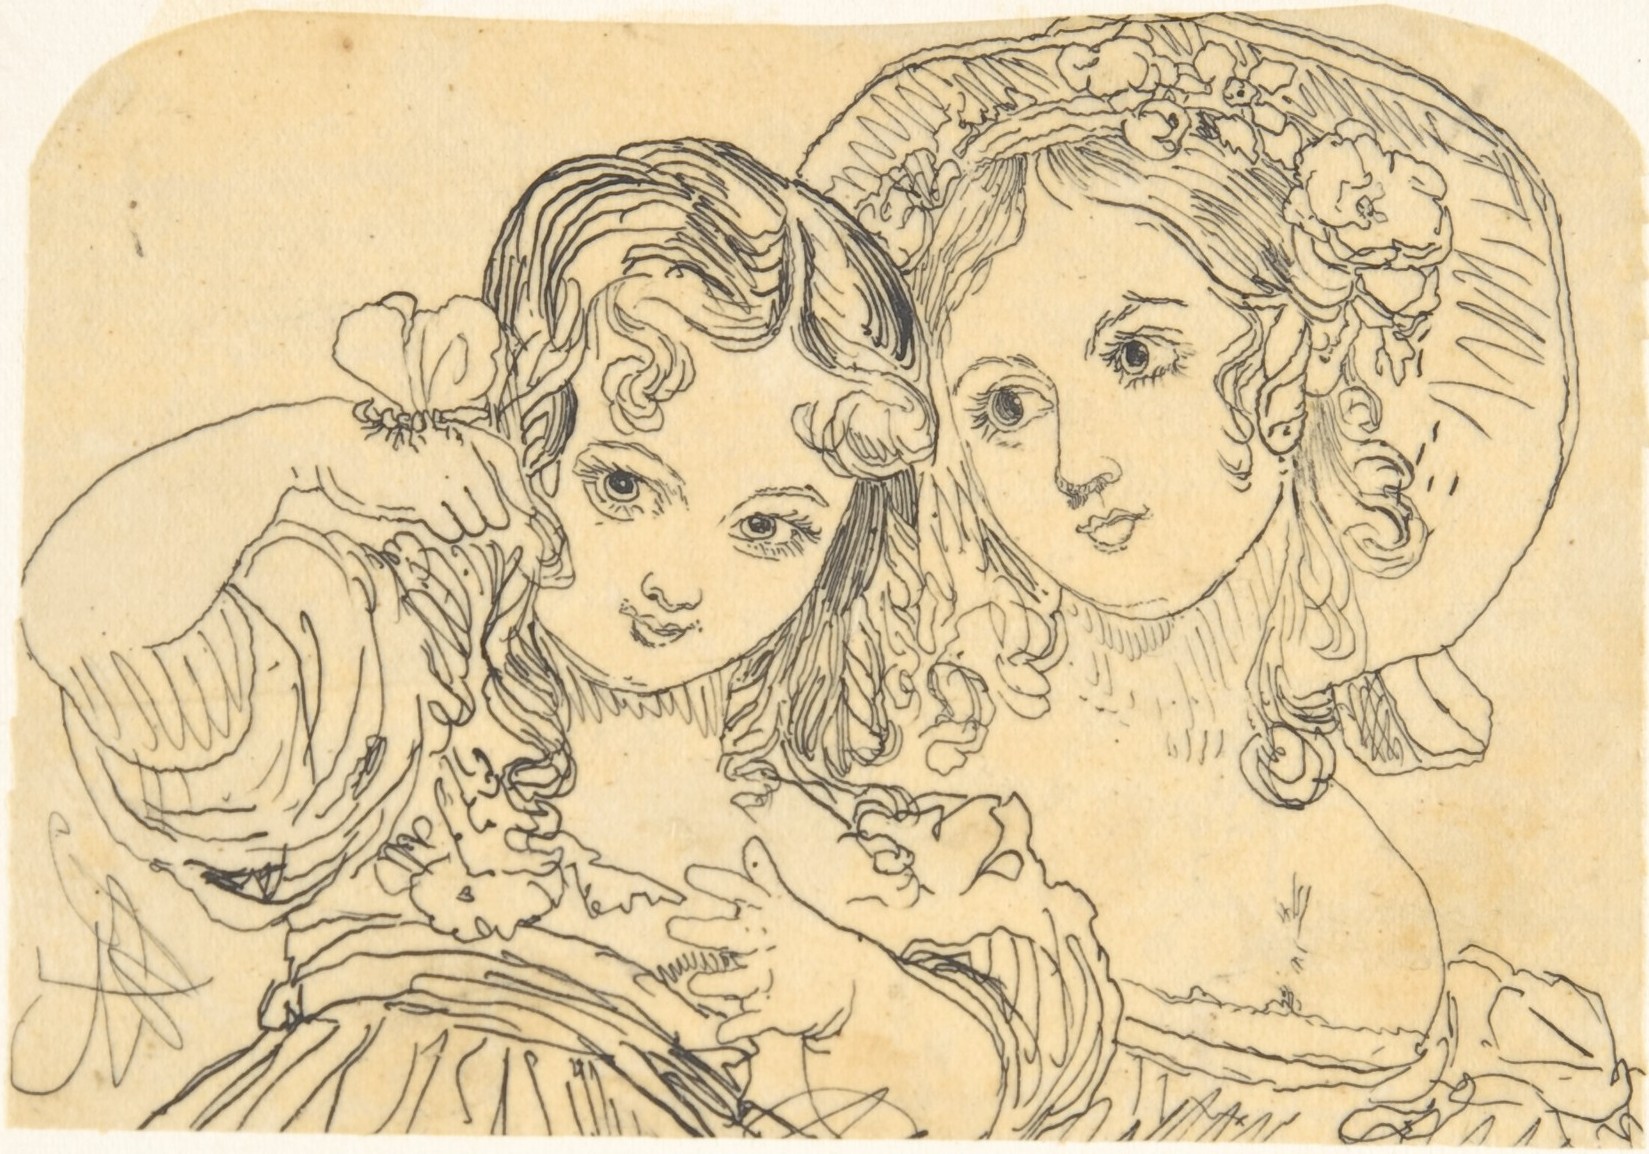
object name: drawing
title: Study of Young Girls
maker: rodolphe bresdin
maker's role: artist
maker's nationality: french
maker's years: 1822-1885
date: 1822-1885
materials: ink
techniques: pen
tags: girls